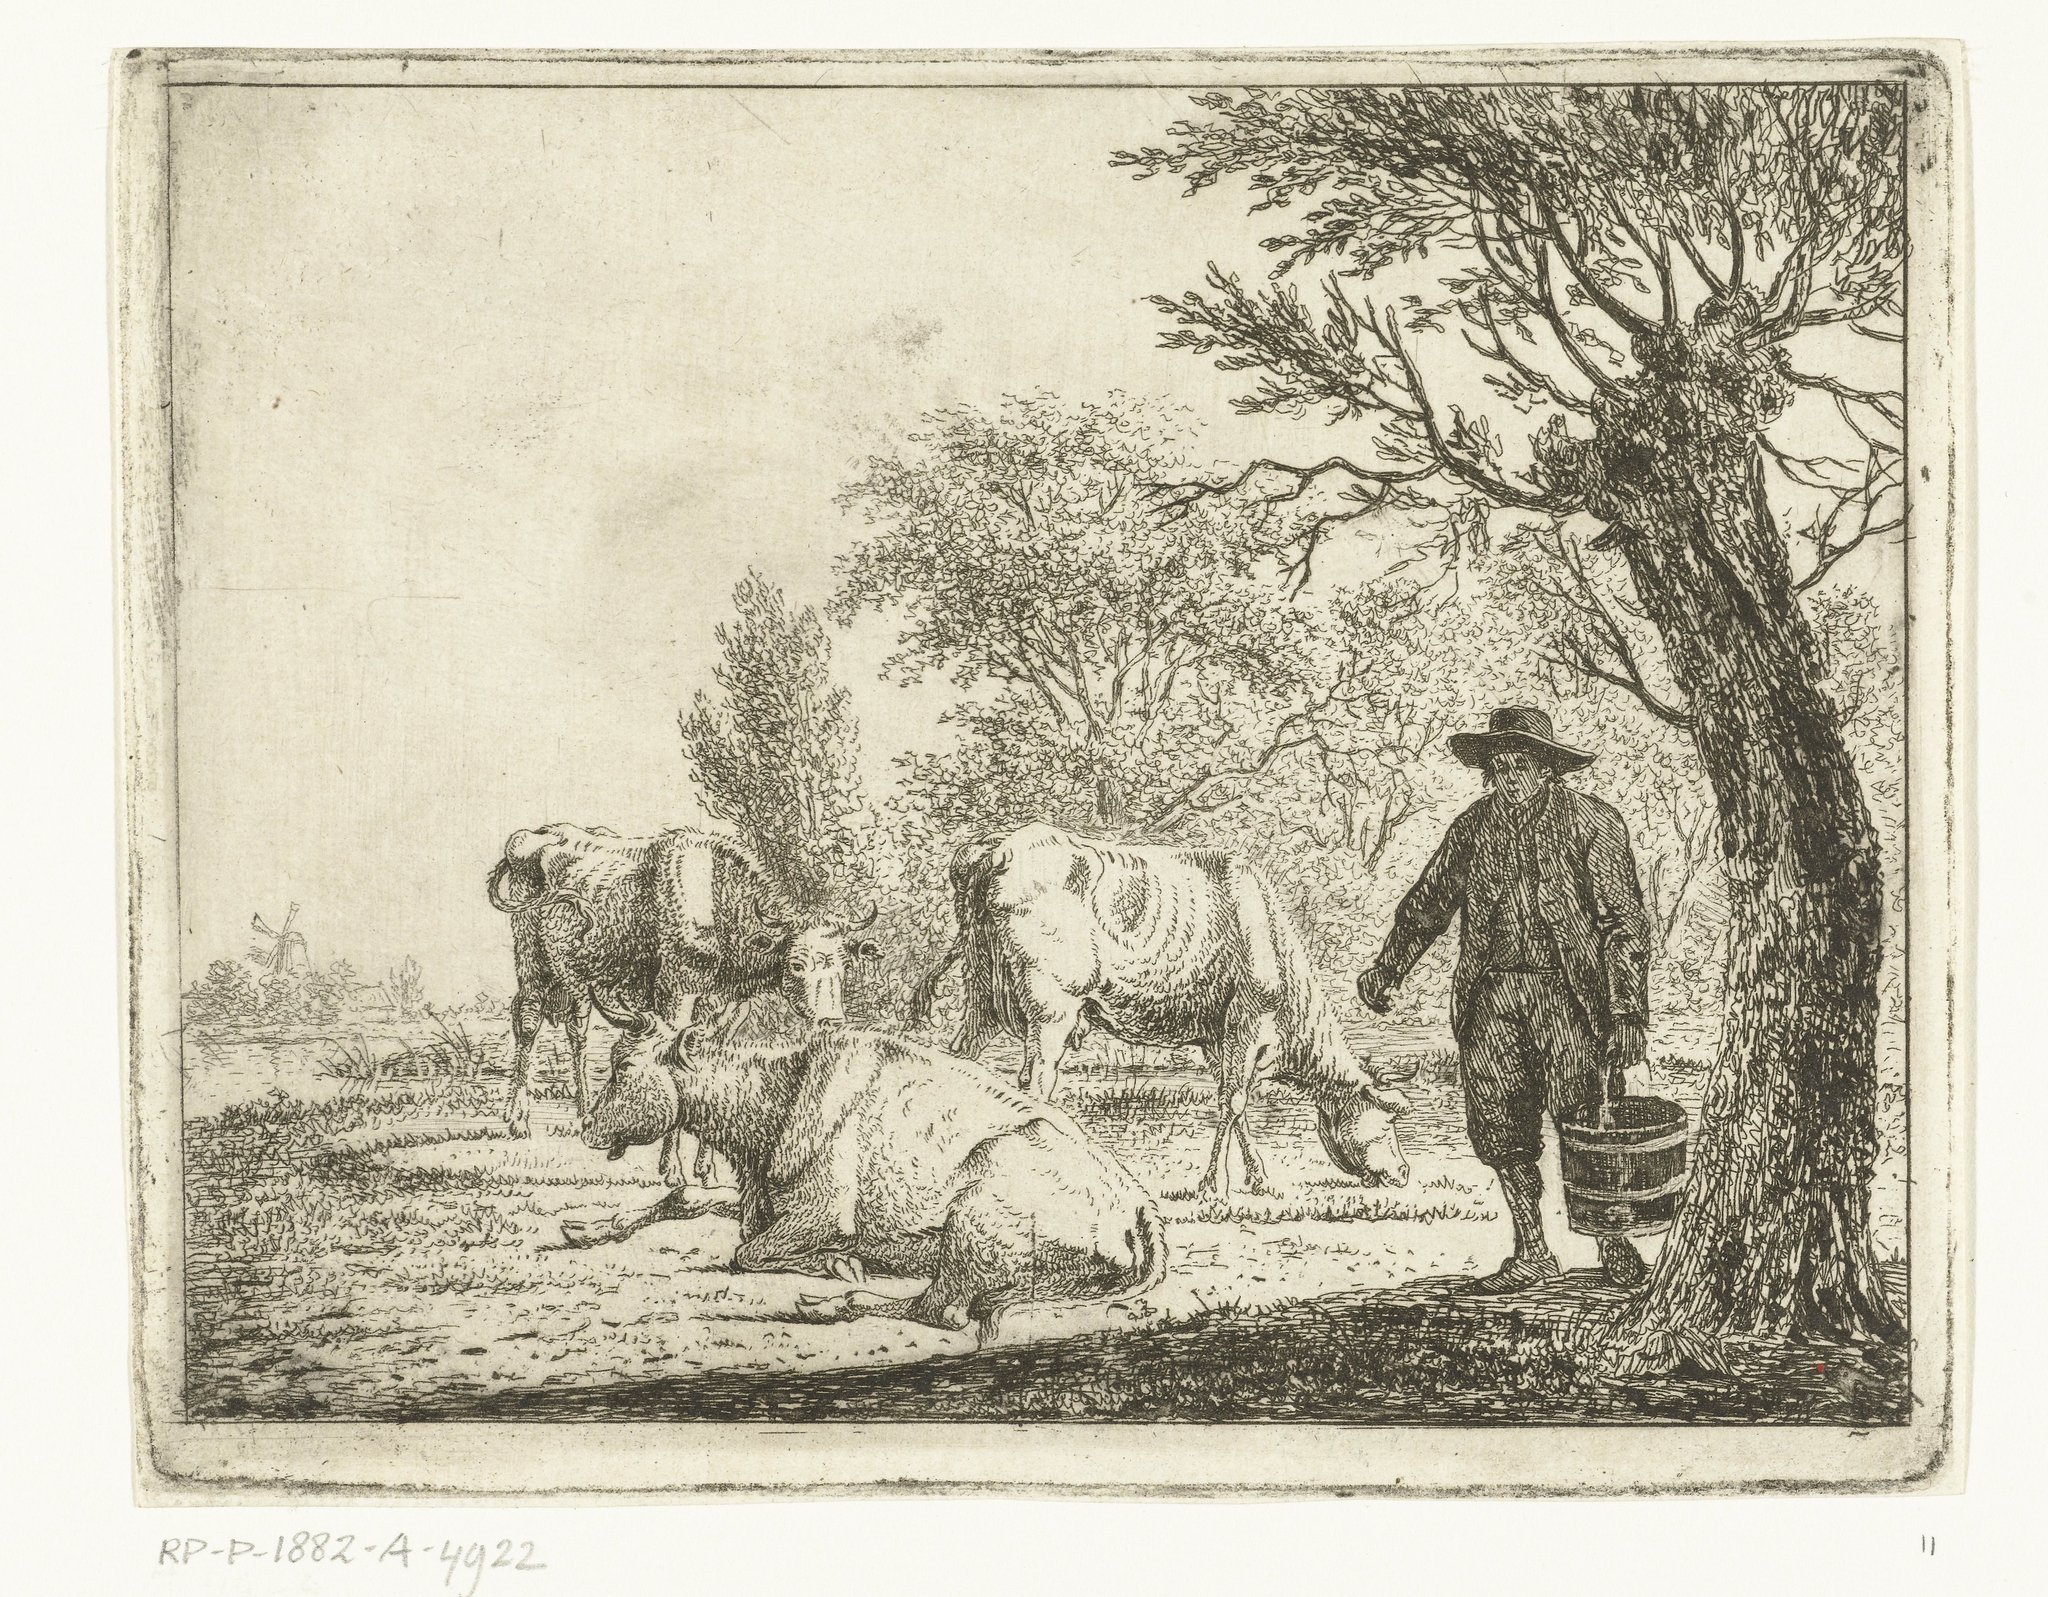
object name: print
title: Weidelandschap met man met emmer bij drie koeien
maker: cornelis bisschop (1762-1829)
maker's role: print maker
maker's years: 1762-1829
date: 1777-1829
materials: paper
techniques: etching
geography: netherlands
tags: wooden container: barrel, cask, bucket, cow, meadow, pasture, transportation of milk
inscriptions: collector's mark: Lugt 2228